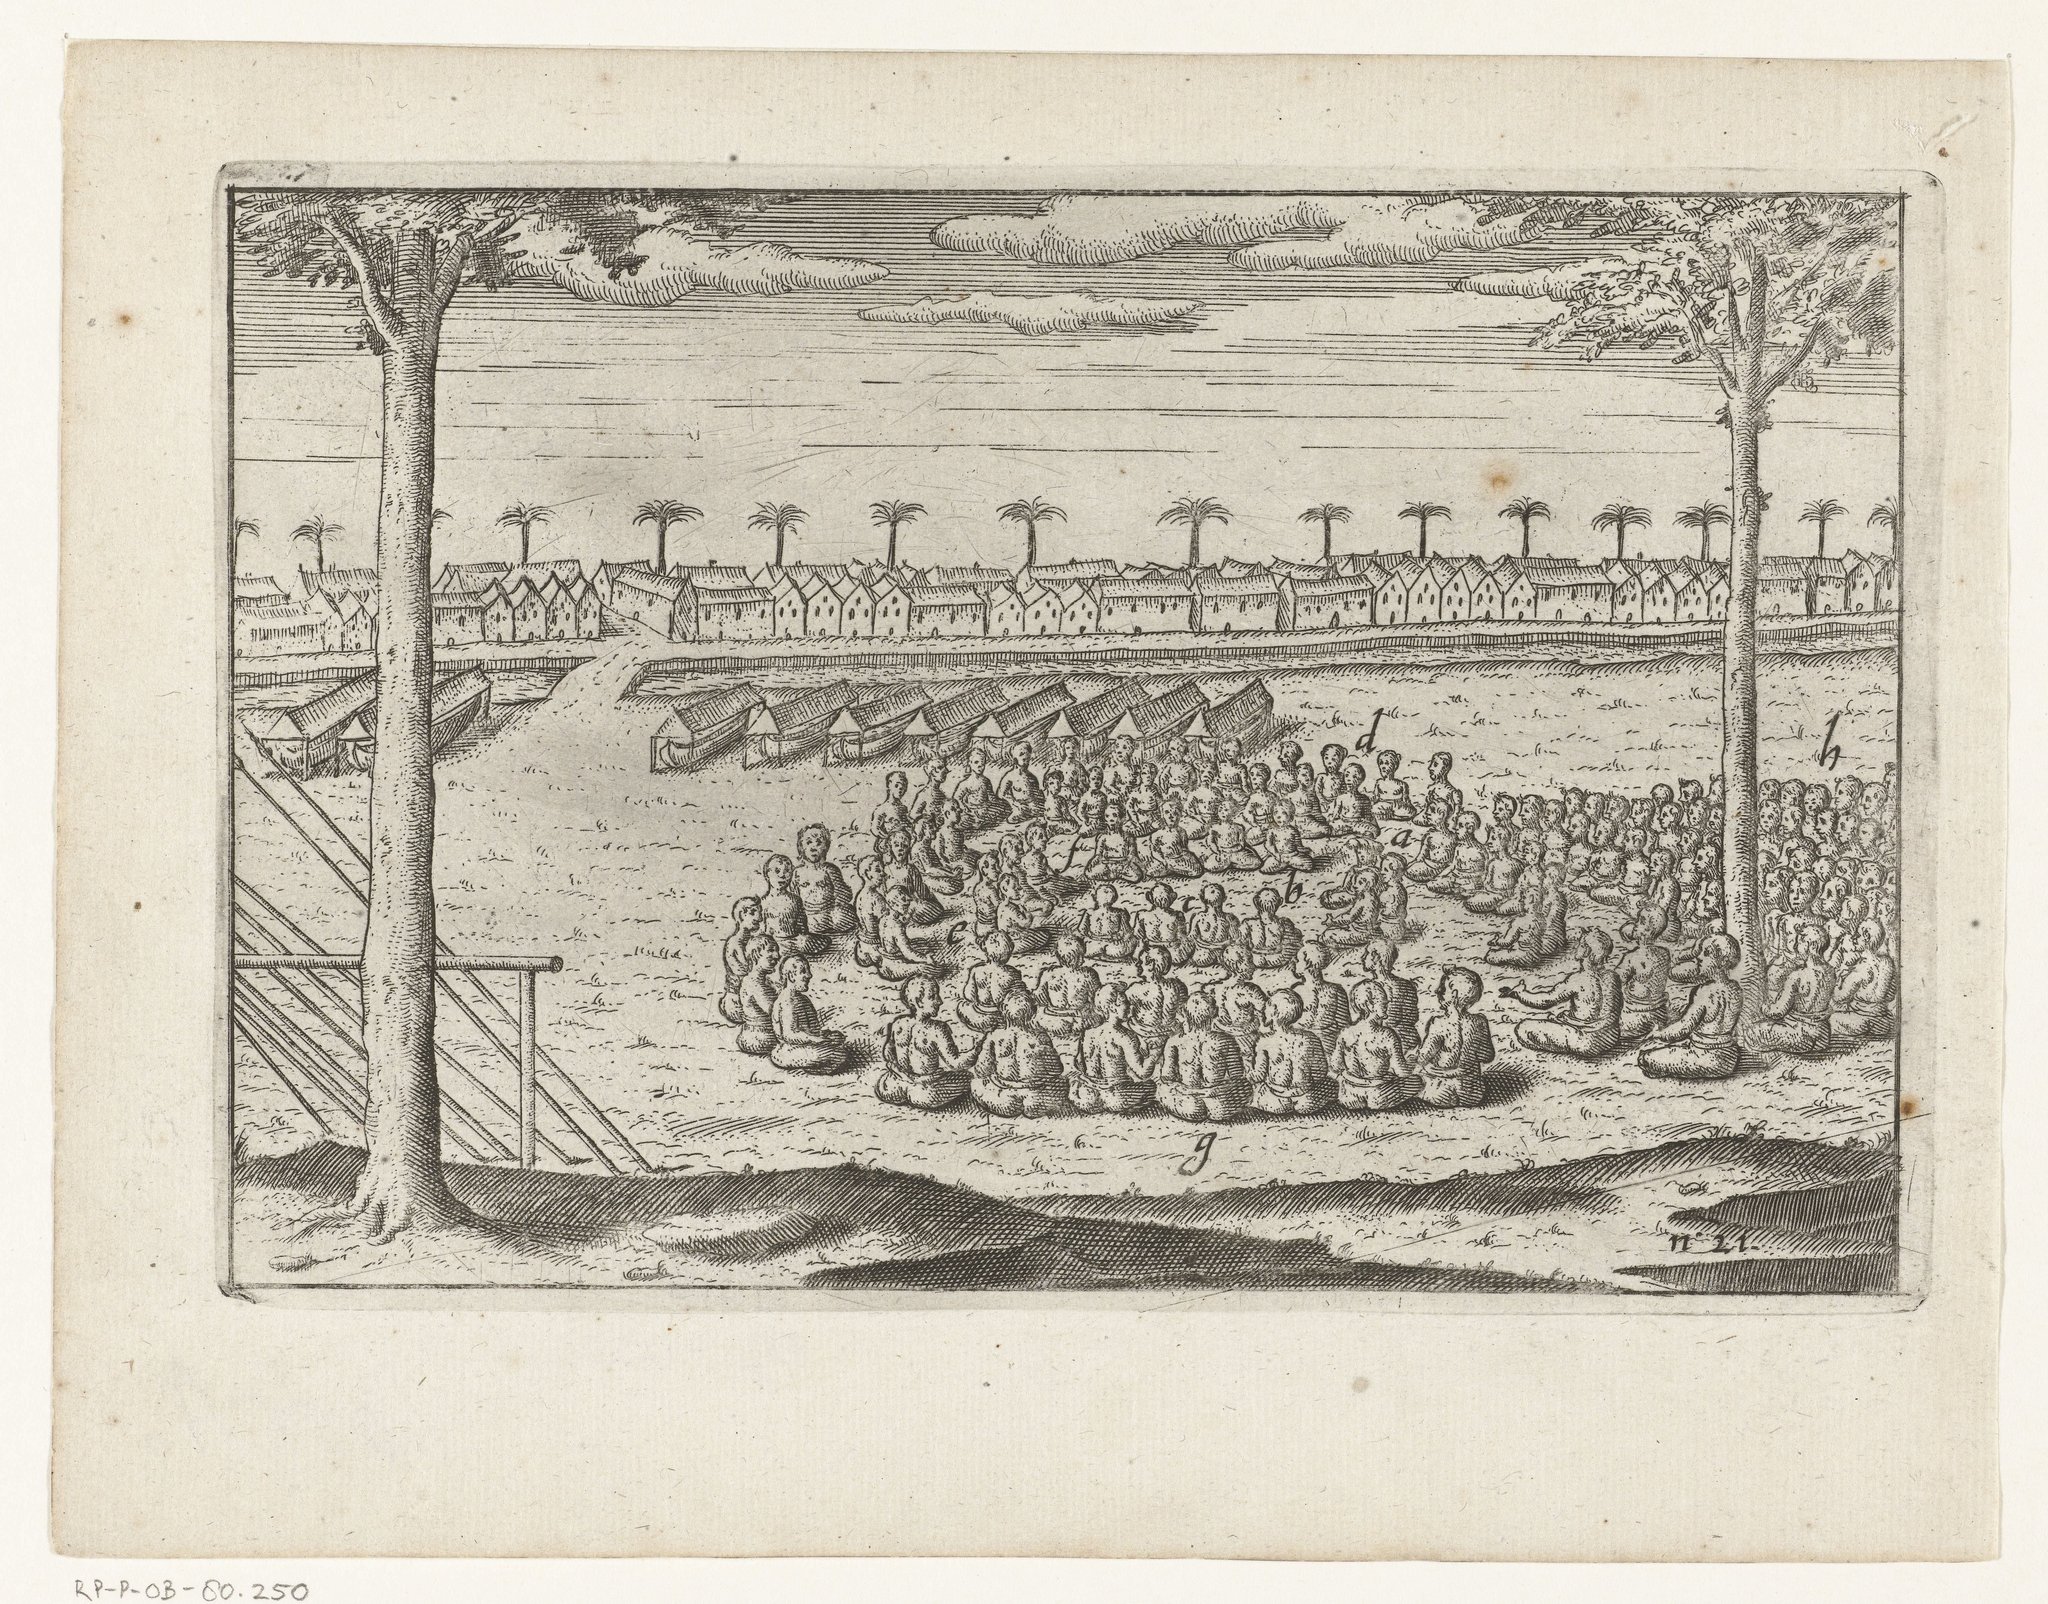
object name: print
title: Krijgsraad te Bantam, 1596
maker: Anonymous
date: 1597-1598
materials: paper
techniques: engraving, etching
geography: northern netherlands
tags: landscapes in tropical and sub-tropical regions, exploration, expedition, voyage of discovery, council of war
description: Gebruikt als illustratie eerst in: Willem Lodewijcksz, D'eerste boeck. Historie van Indien, waer inne verhaelt is de avontueren die de Hollandtsche schepen bejeghent zijn, Cornelis Claes, Amsterdam 1598. In deze opgewerkte staat gebruikt in: De Eerste Schipvaerd der Hollandsche Natie naer Oost-Indien, waer inne verhaelt wordt al wat haer sonderlings onder wegen bejegent is ... ghetrocken uyt verscheyden Iournalen ofte dagh-registers daer van ghemaeckt, zeer vermaeckelijck ende nut om lesen. Opgenomen in: I. Commelin, Begin ende voortgangh, van de Vereenighde Nederlantsche Geoctroyeerde Oost-Indische Compagnie, J. Janssonius, Amsterdam 1646. Genummerd: 21.